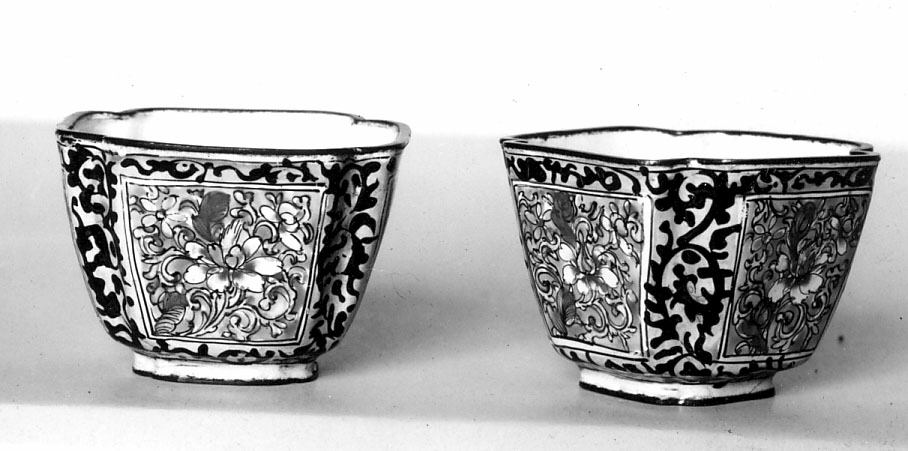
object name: cup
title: Square Cup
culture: chinese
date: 1801-1900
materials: enamel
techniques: painting